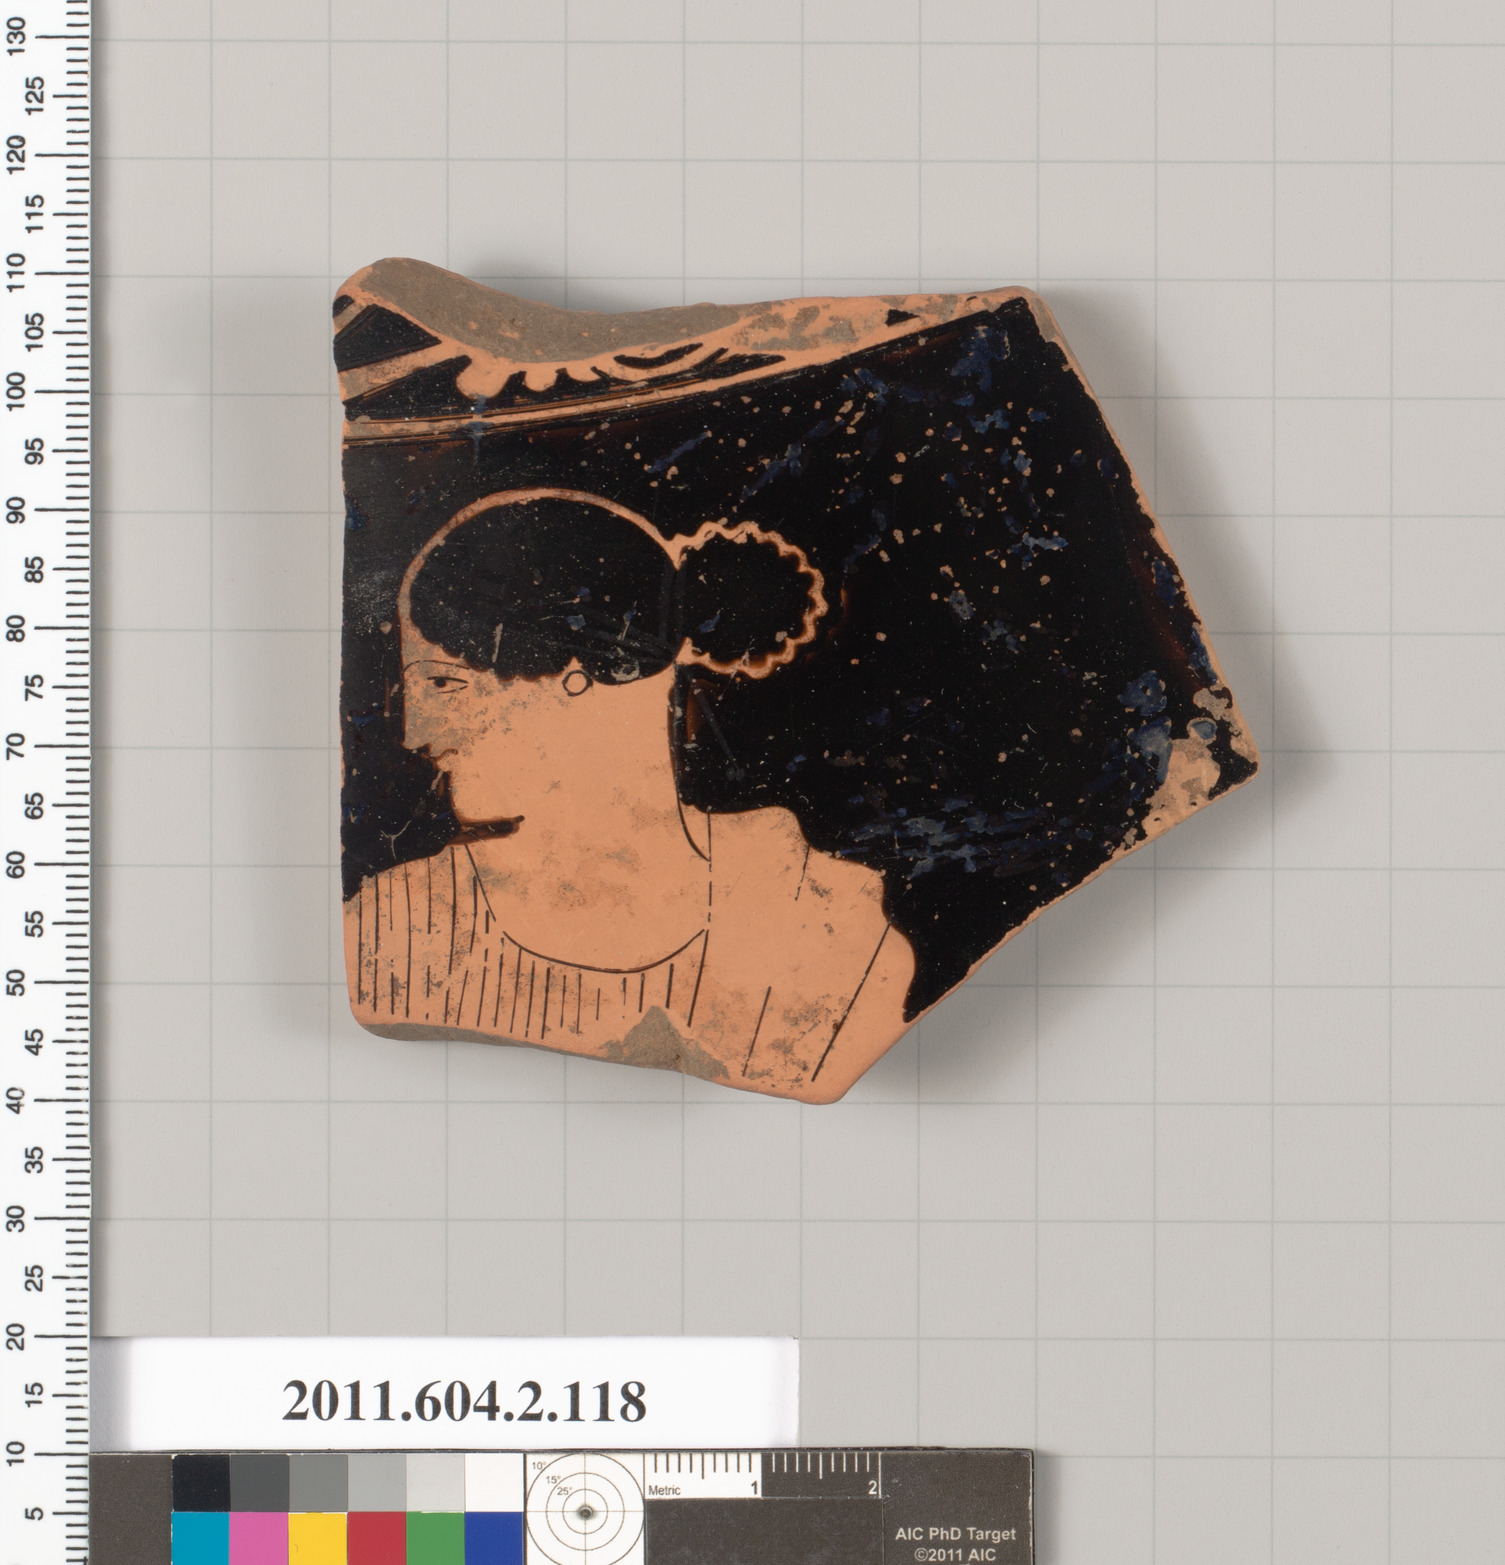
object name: pelike fragment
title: Terracotta fragment of a pelike (jar)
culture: greek, attic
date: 460-450 BCE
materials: terracotta